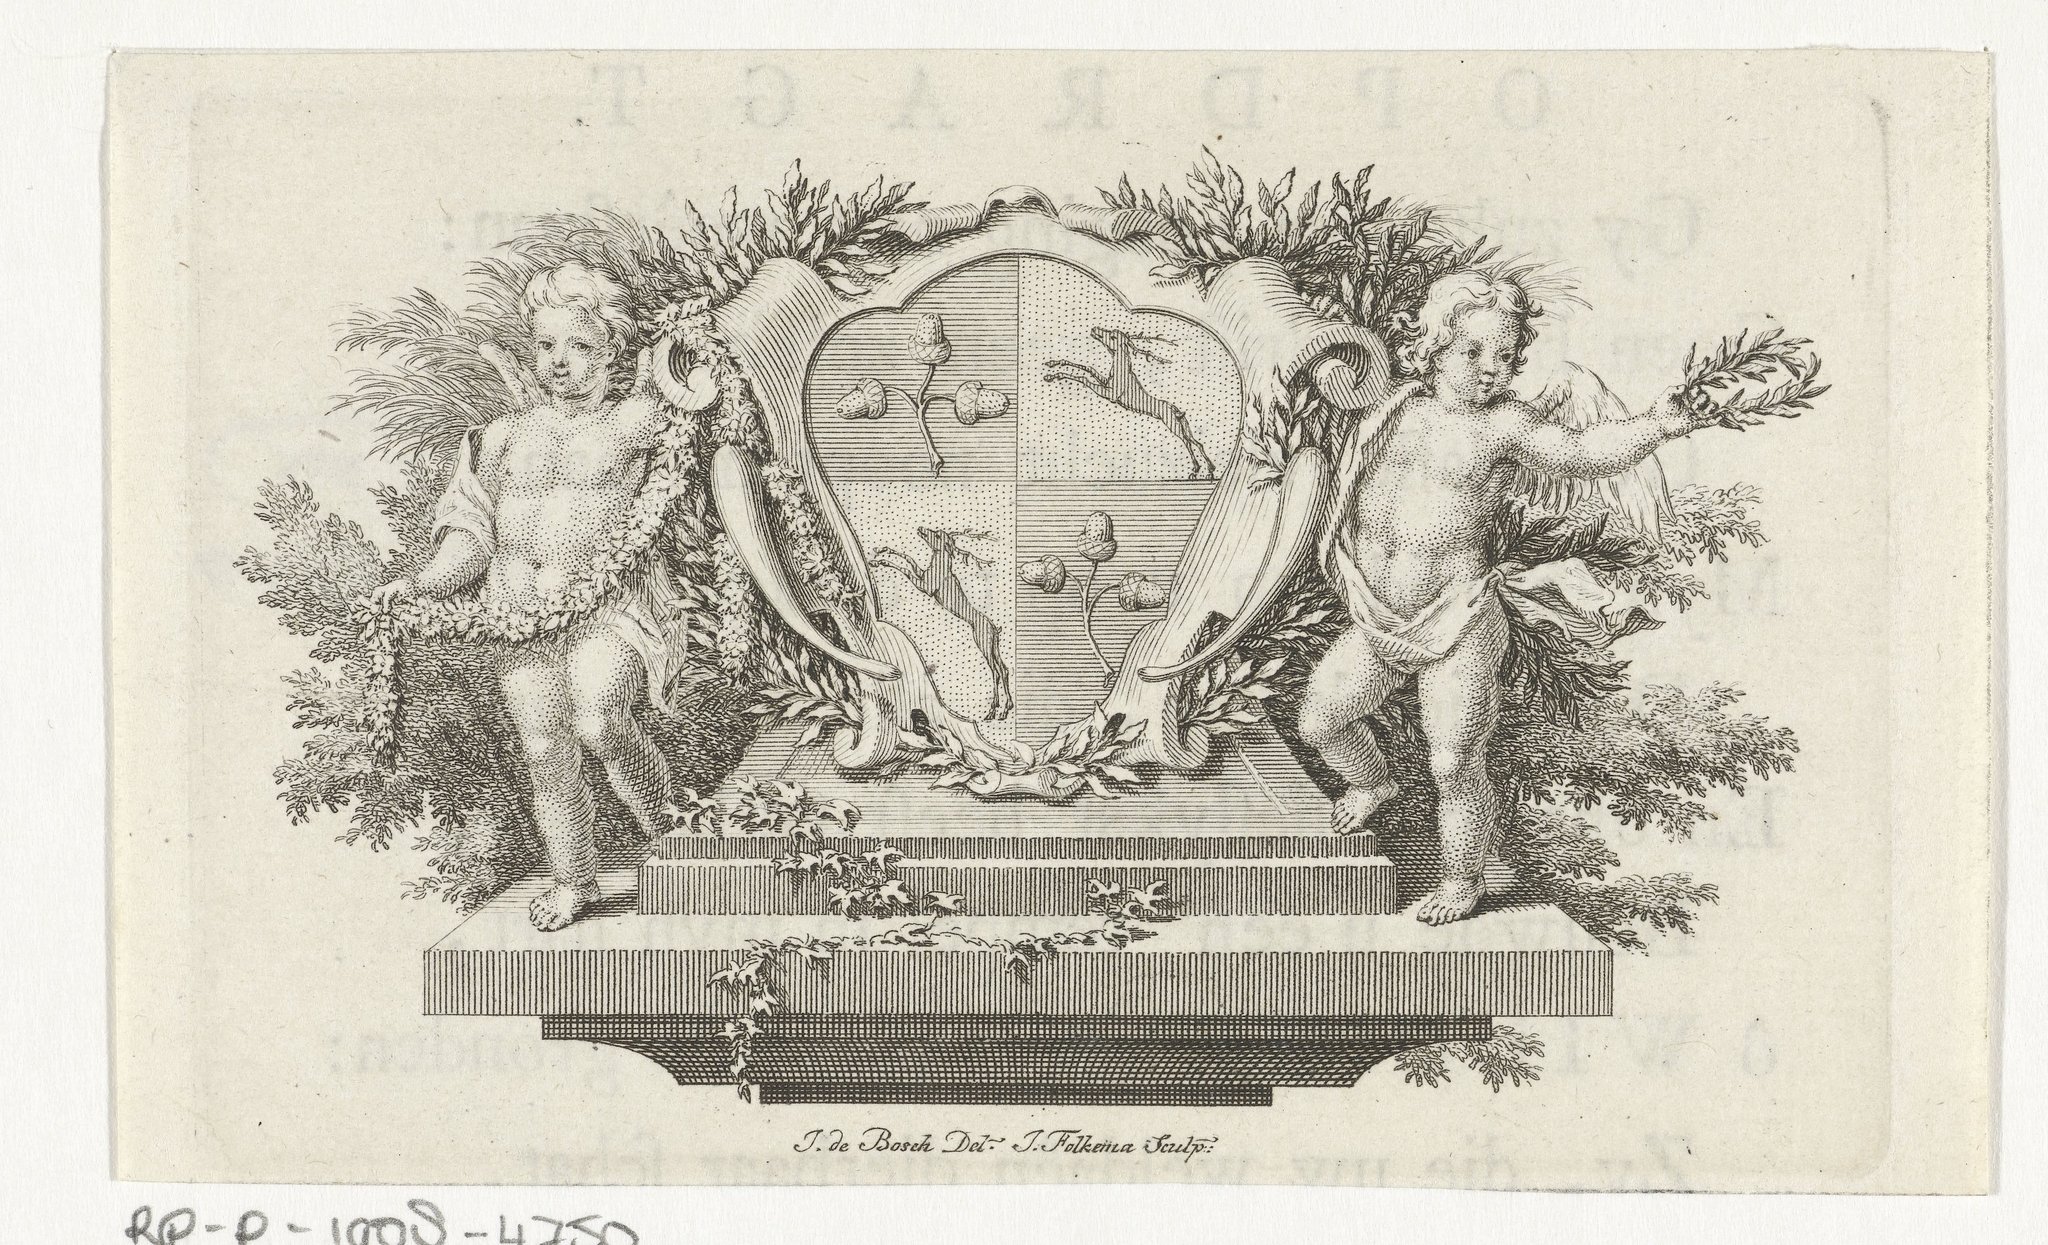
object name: book illustration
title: Wapenschild geflankeerd door putti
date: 1723-1767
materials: paper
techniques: etching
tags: cupids: 'amores', 'amoretti', 'putti', armorial bearing, heraldry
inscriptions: collector's mark: Lugt 2228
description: Een met eikeltjes en herten versierd wapenschild wordt geflankeerd door twee putti met een bloemen- en lauwerkrans.